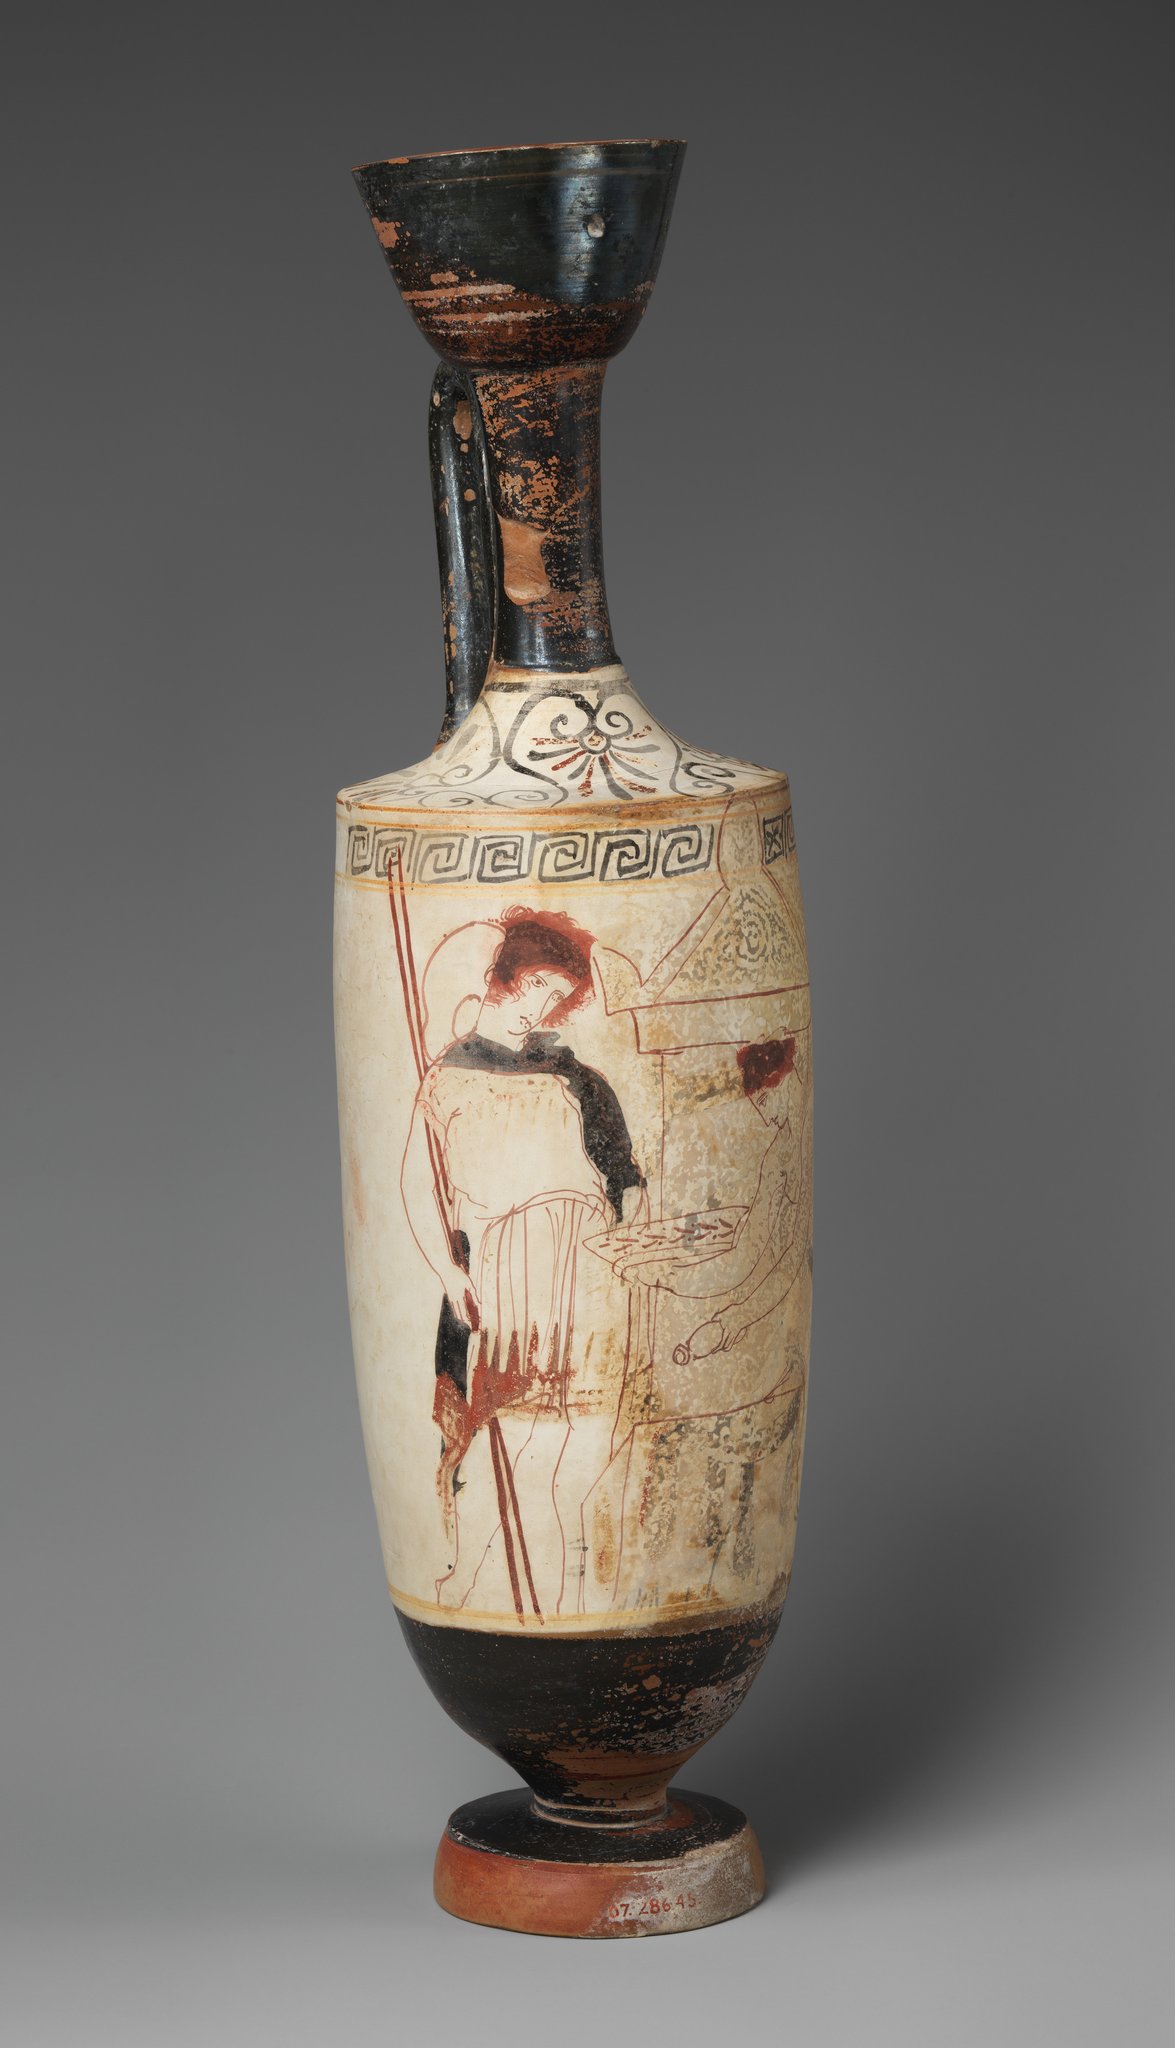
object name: lekythos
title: Terracotta lekythos (oil flask)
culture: greek, attic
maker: group r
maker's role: artist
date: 420-400 BCE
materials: terracotta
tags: tombs,men,women